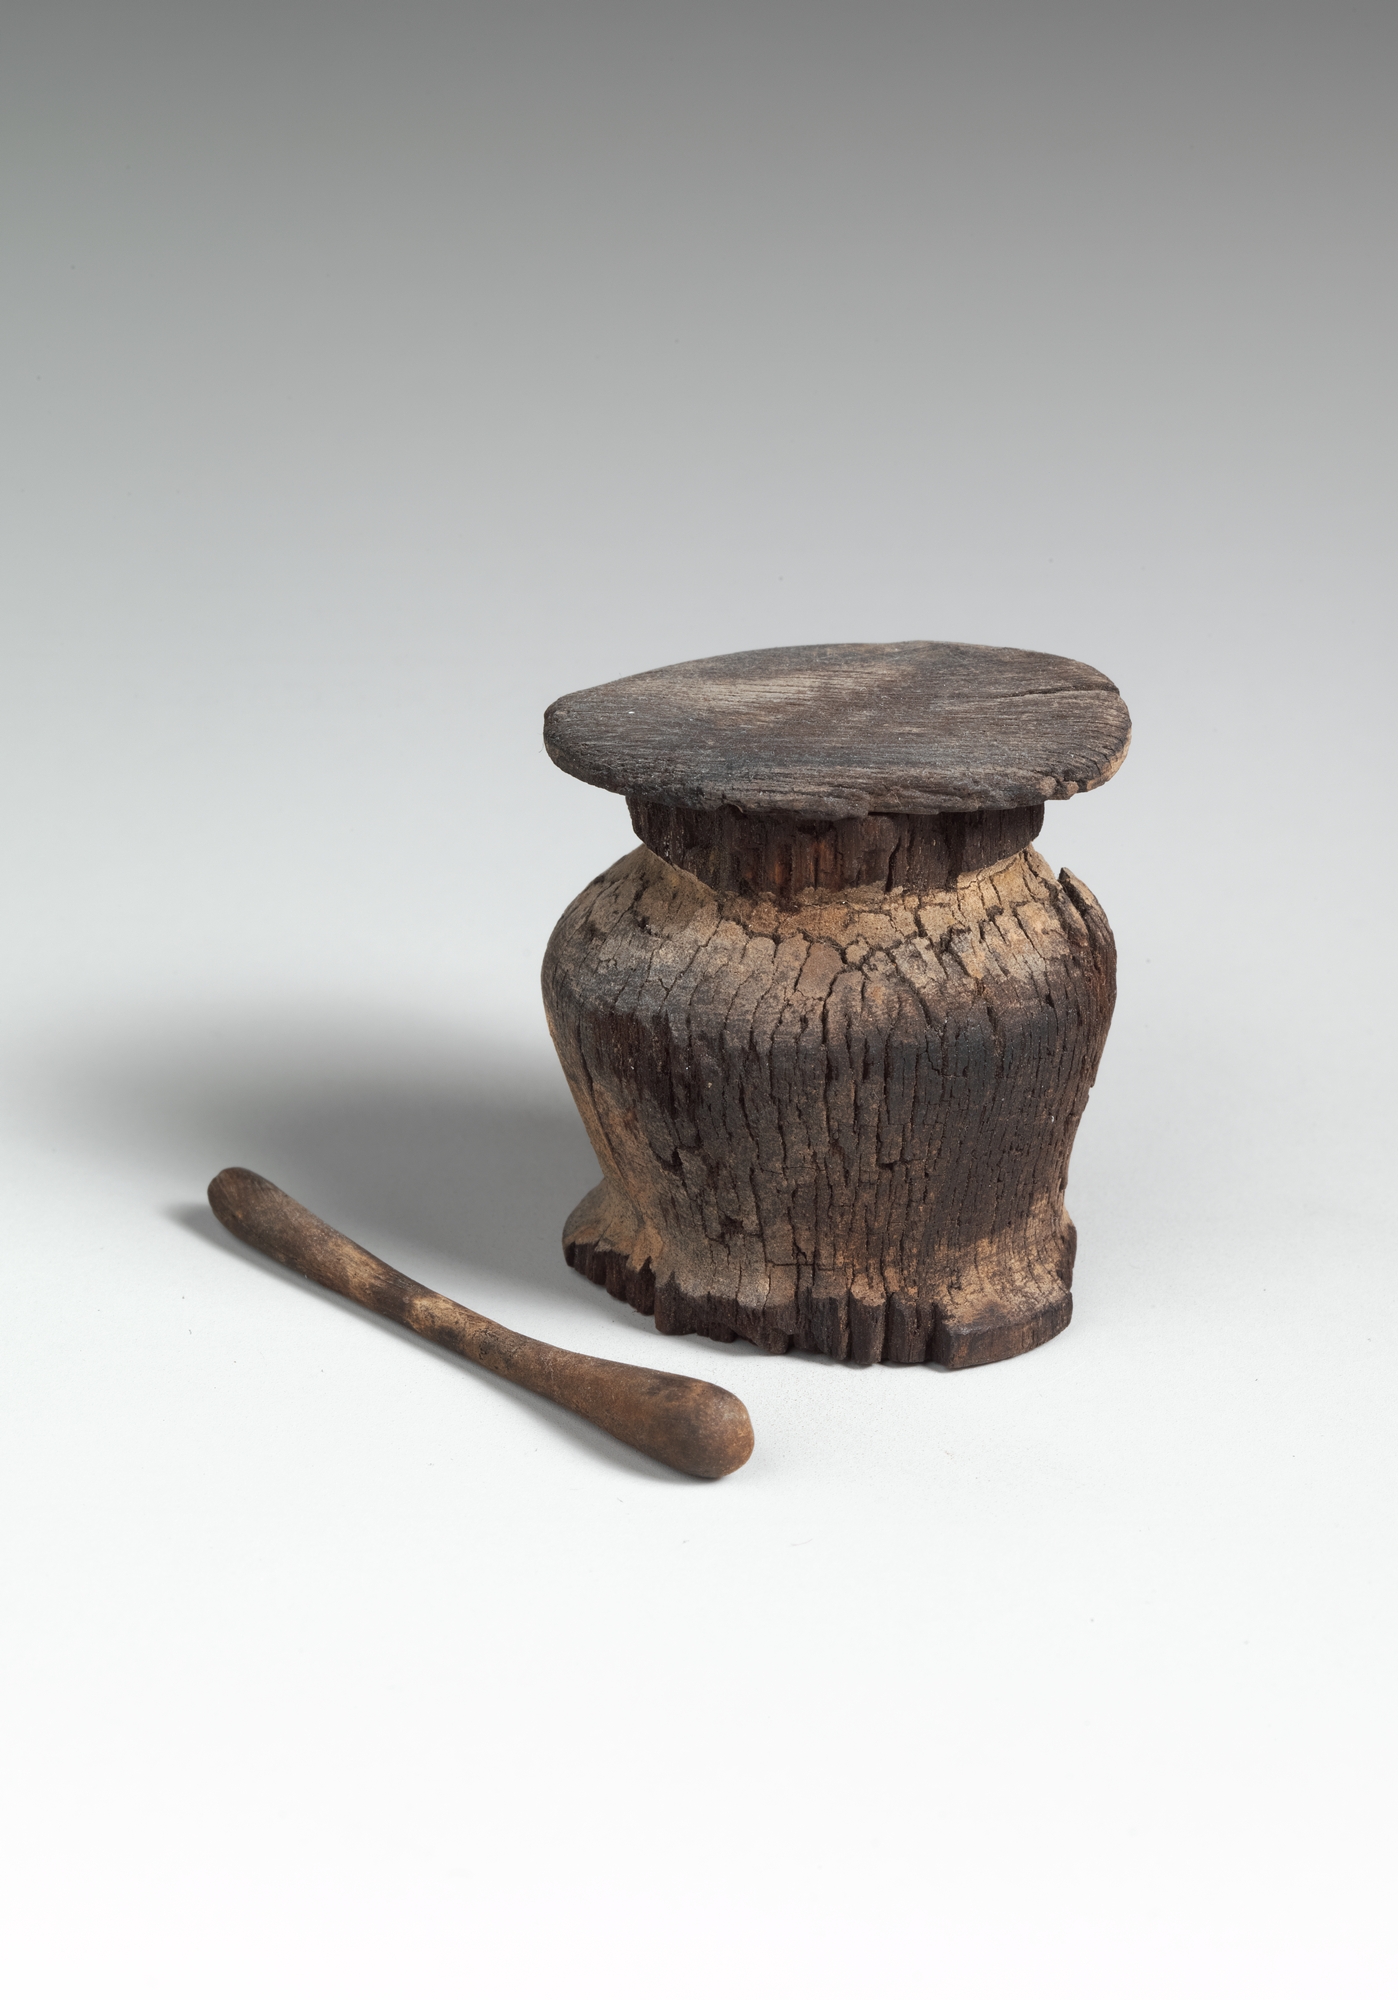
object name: kohl jar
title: Kohl Jar (with Stick 16.10.361c)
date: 1635-1458 BCE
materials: paint, wood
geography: egypt